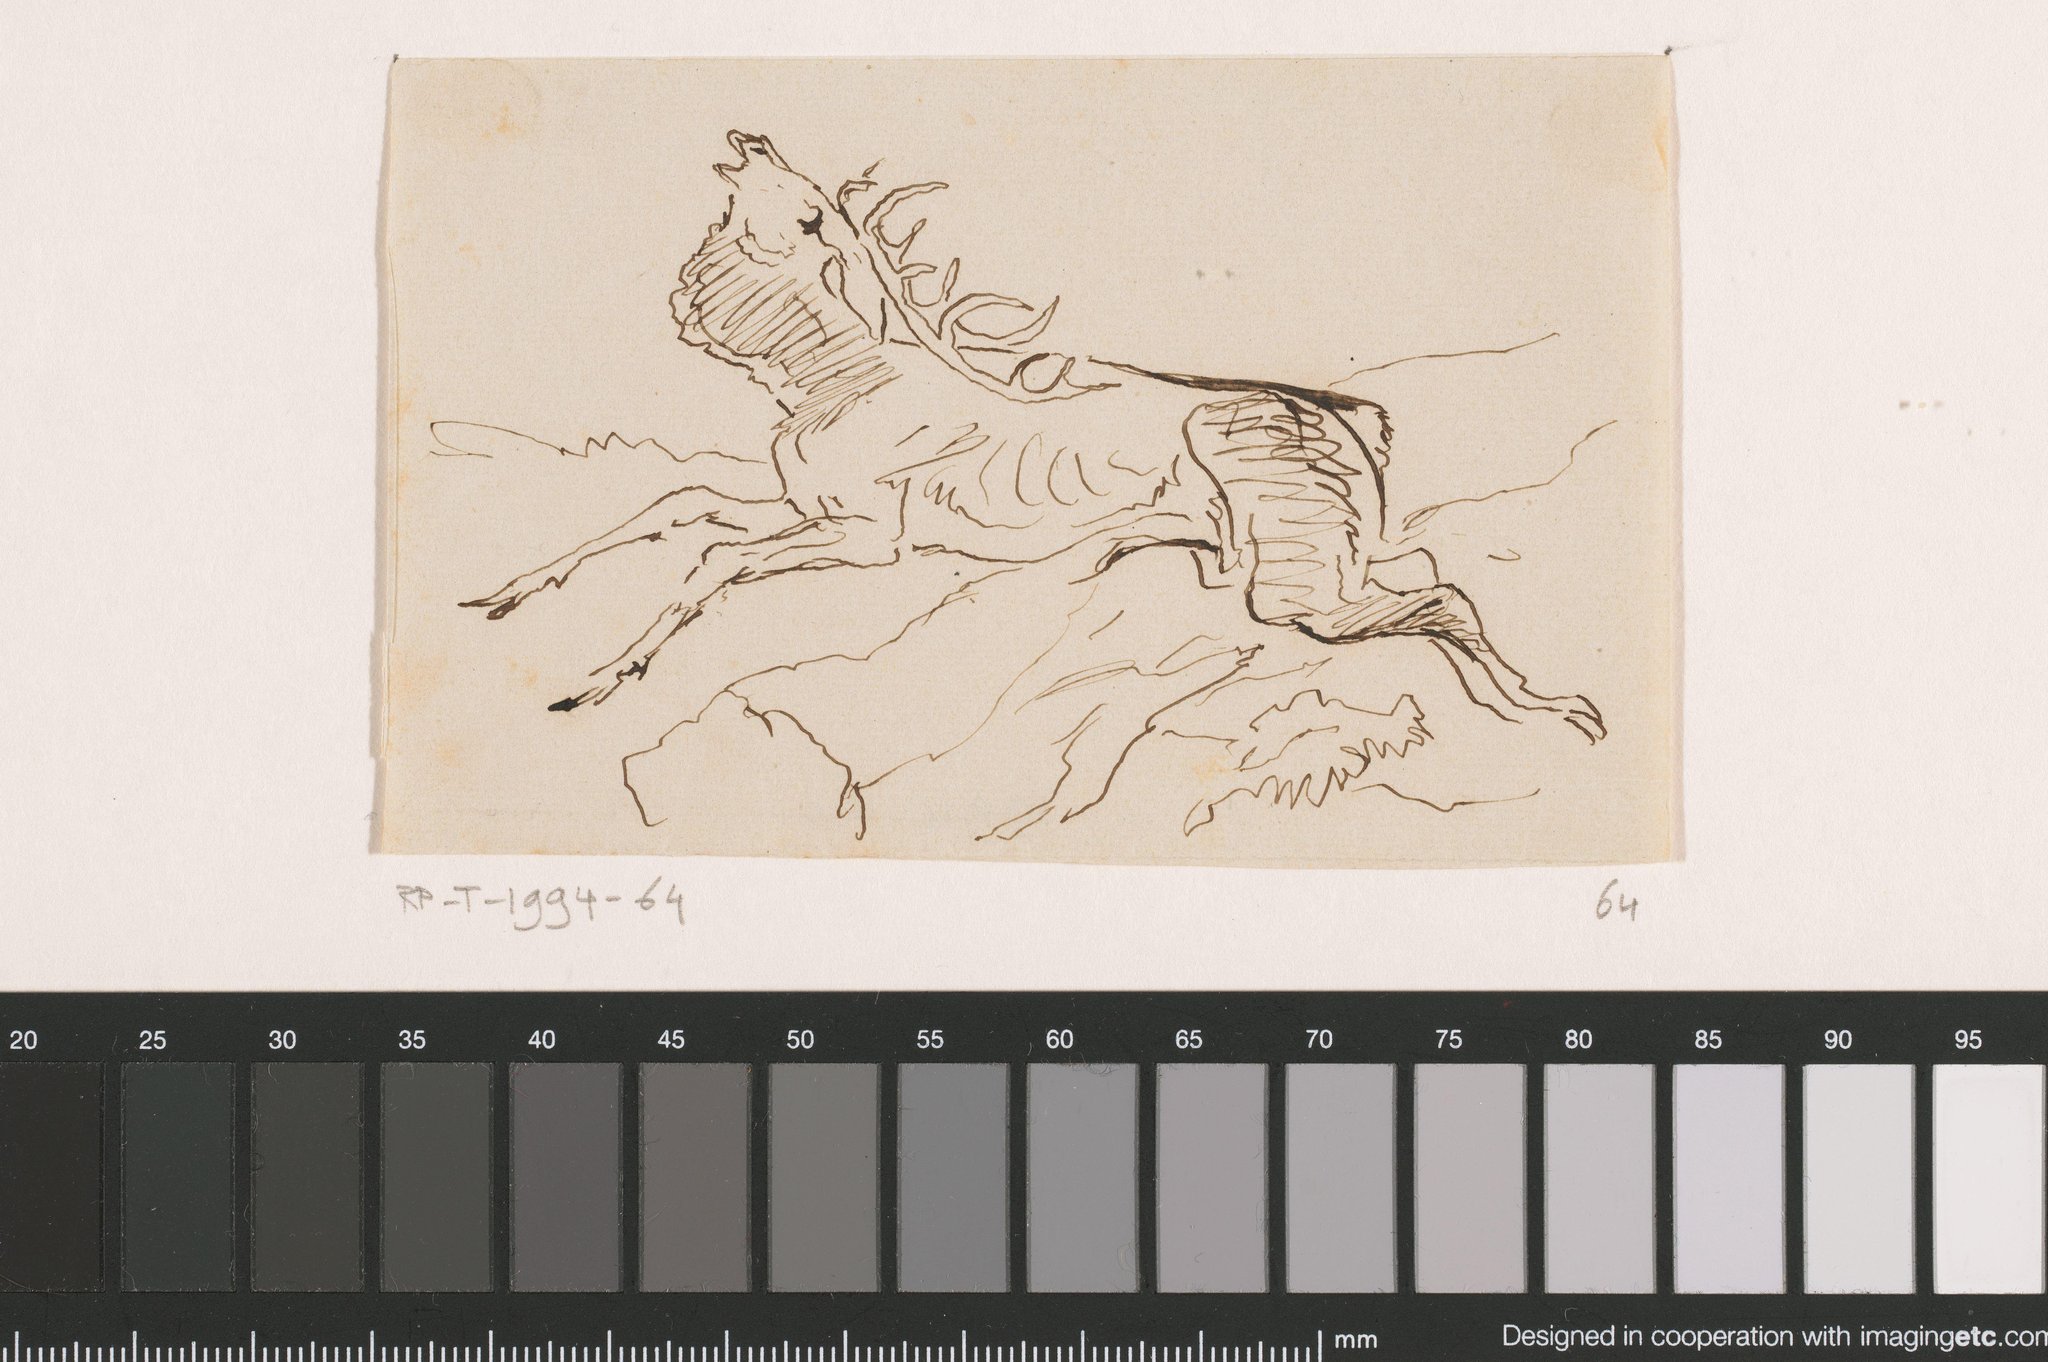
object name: drawing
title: Rennend hert met opgeheven kop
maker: johannes tavenraat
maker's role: draughtsman, painter, print maker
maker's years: 1809-1881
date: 1819-1881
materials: ink, paper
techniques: pen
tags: hoofed animals: deer